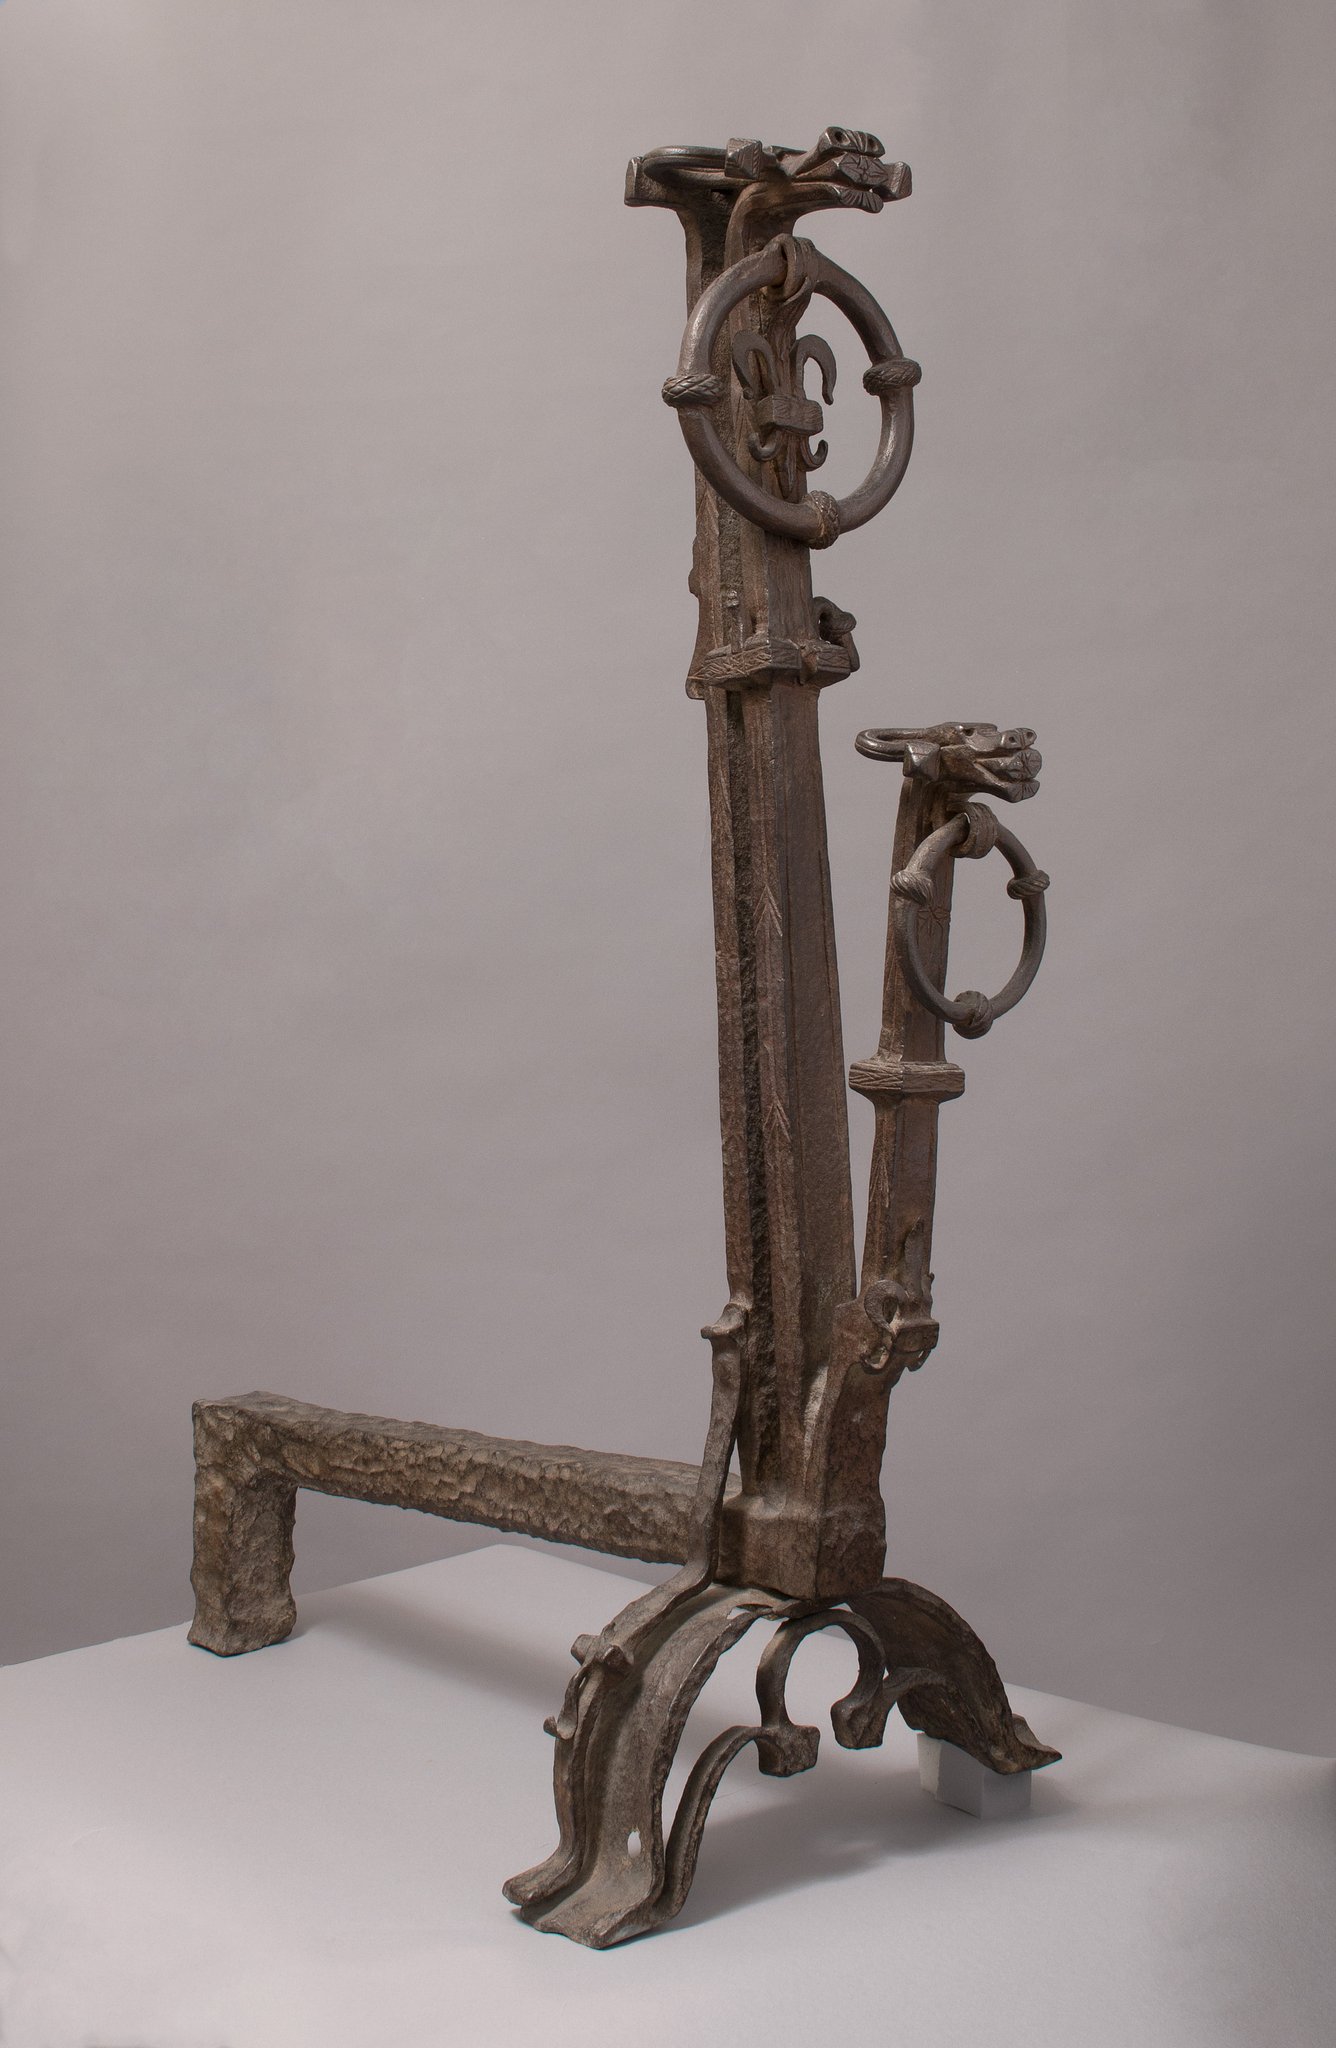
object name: andiron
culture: french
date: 1367-1400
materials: iron